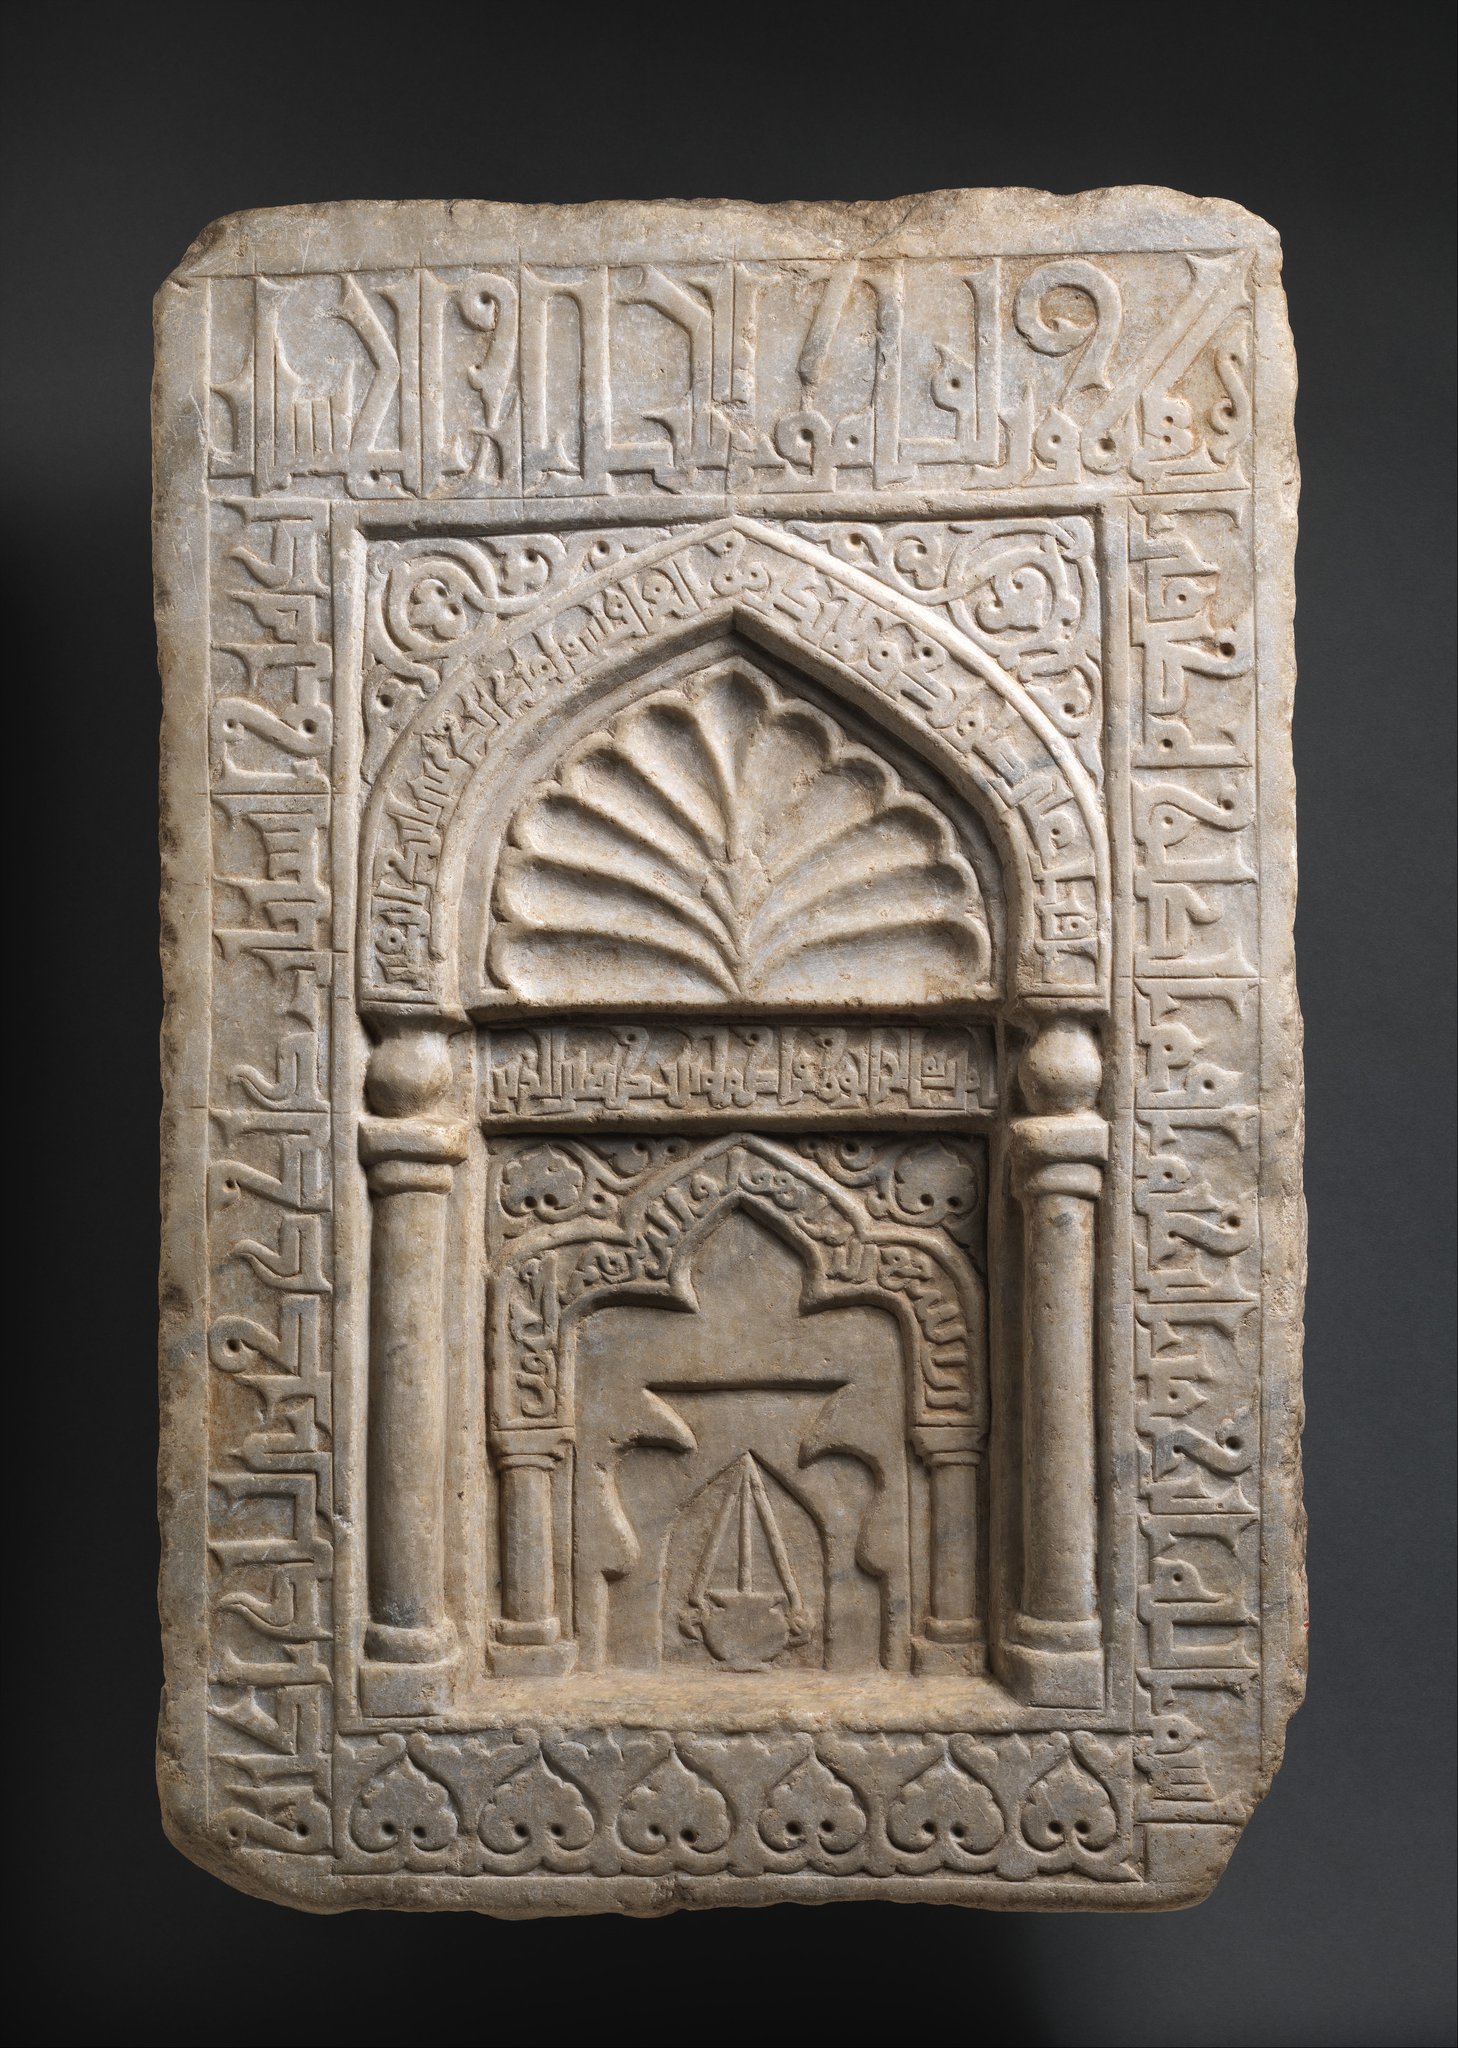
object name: panel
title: Panel of al-Khatun (the lady) Fatima bint Zahir al-Din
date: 1001-1200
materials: marble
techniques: carving, relief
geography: iran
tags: arabic